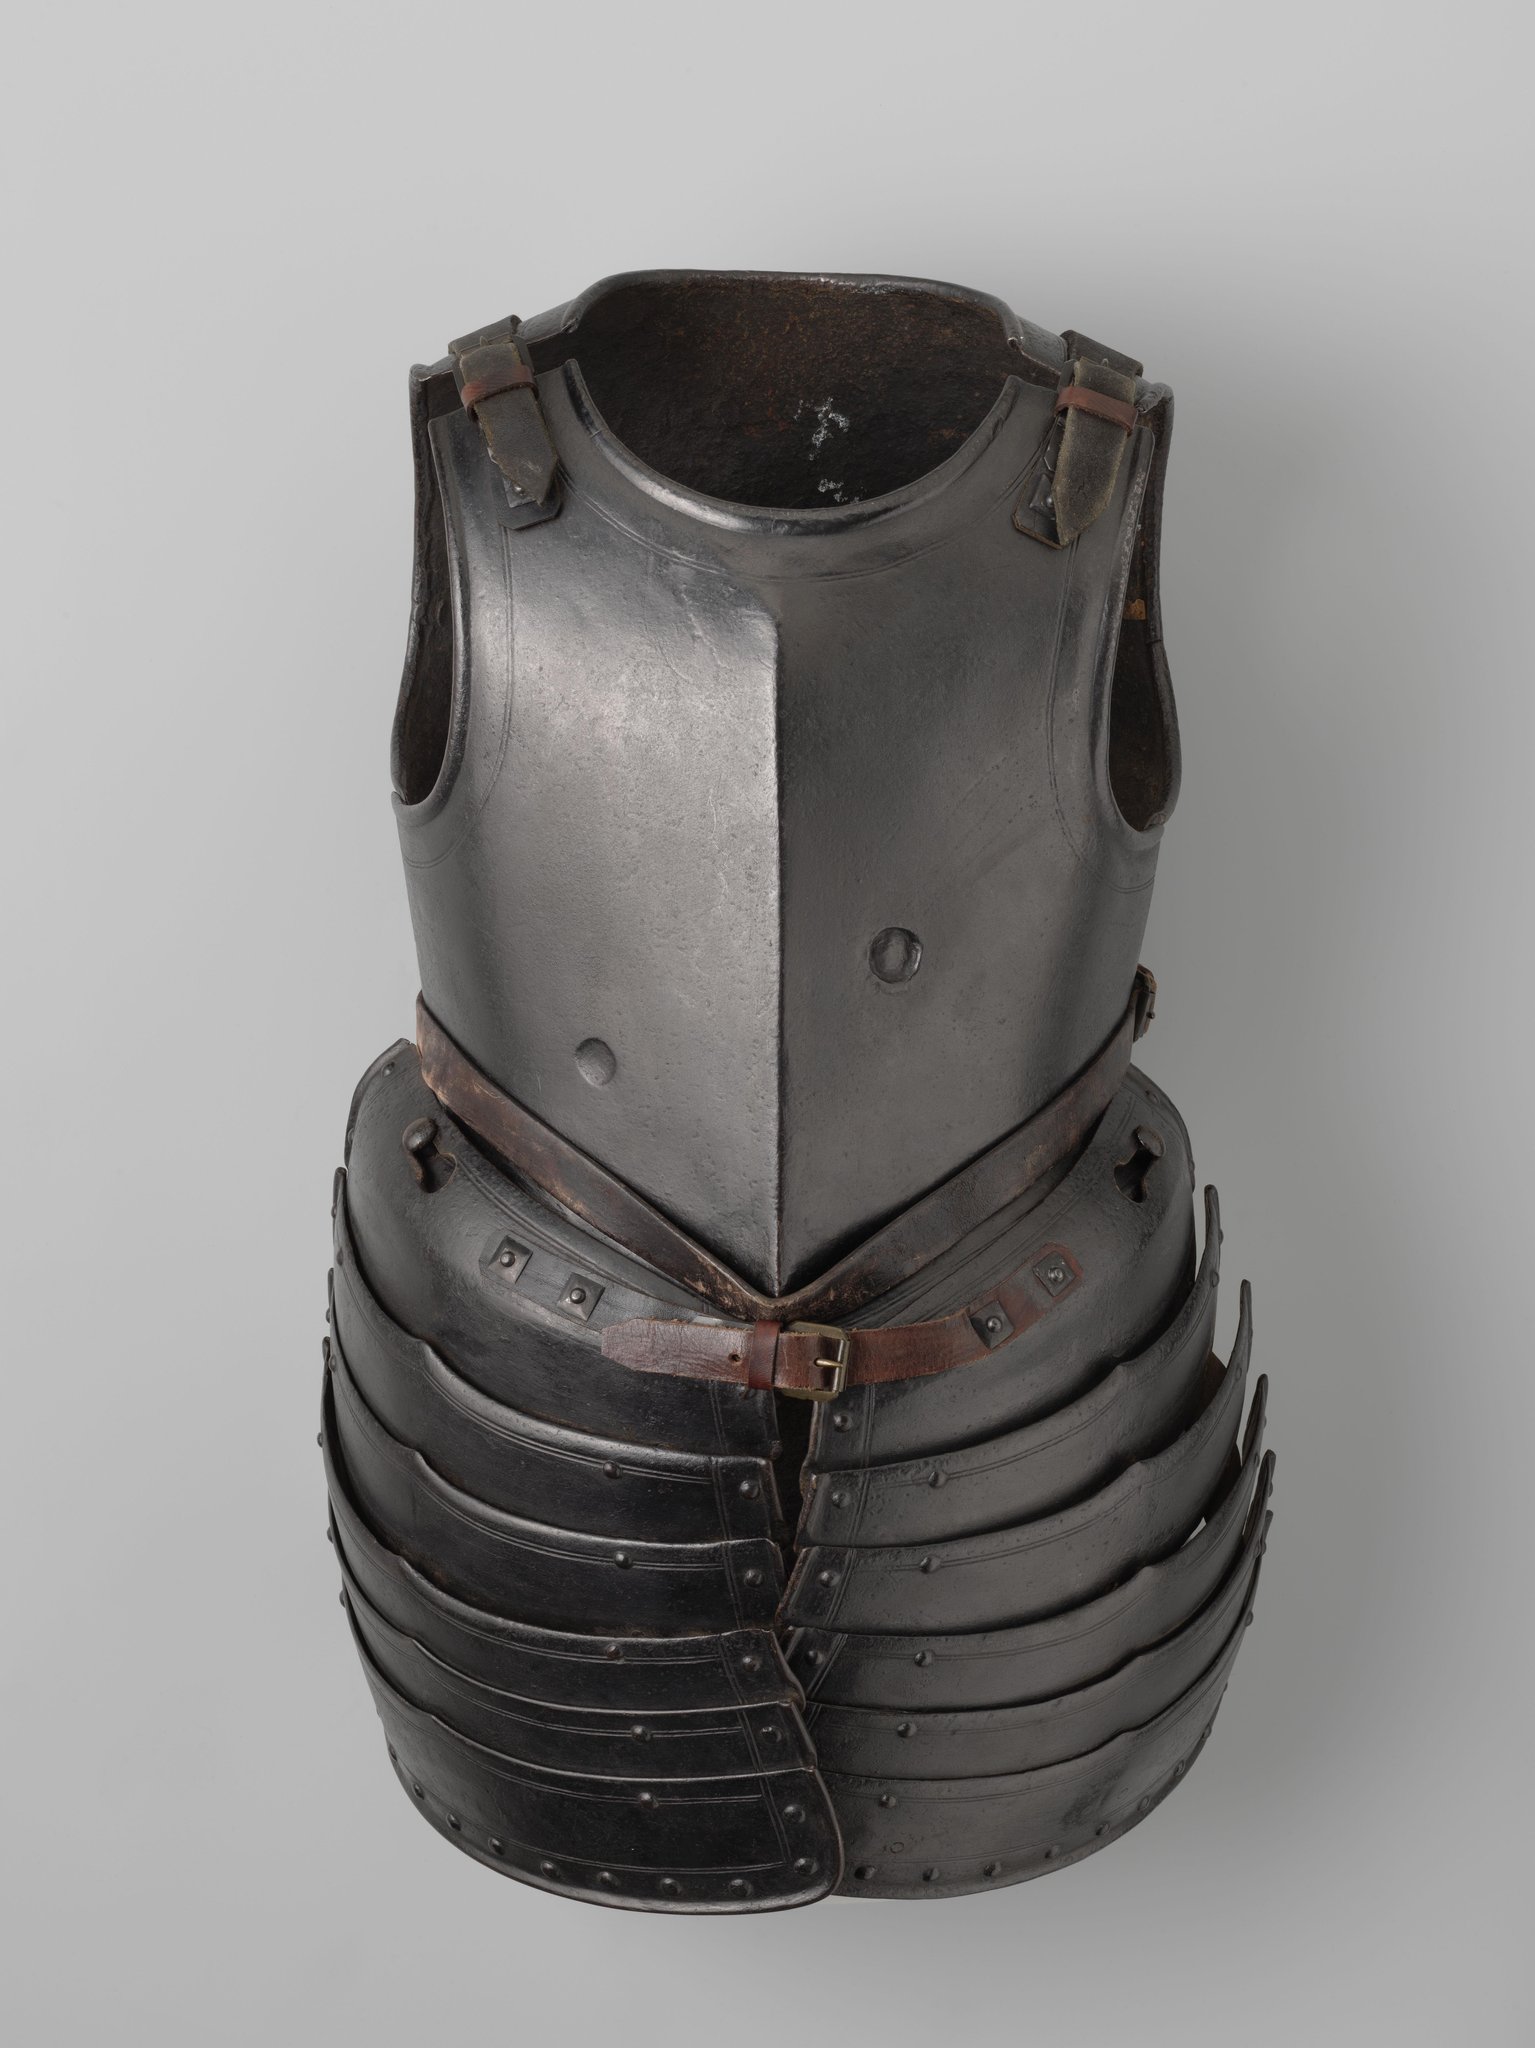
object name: dijbeenplaat, dijstuk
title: Dijstuk van het harnas van Piet Hein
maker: Anonymous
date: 1600-1629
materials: iron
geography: netherlands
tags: delfshaven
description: Buikbedekking van een zwart geverfde wapenrusting, naar men wil van Piet Hein. De buikbedekking hoort bij vijf delen van de wapenrusting (NG-NM-527-A t/m NG-NM-527-F).